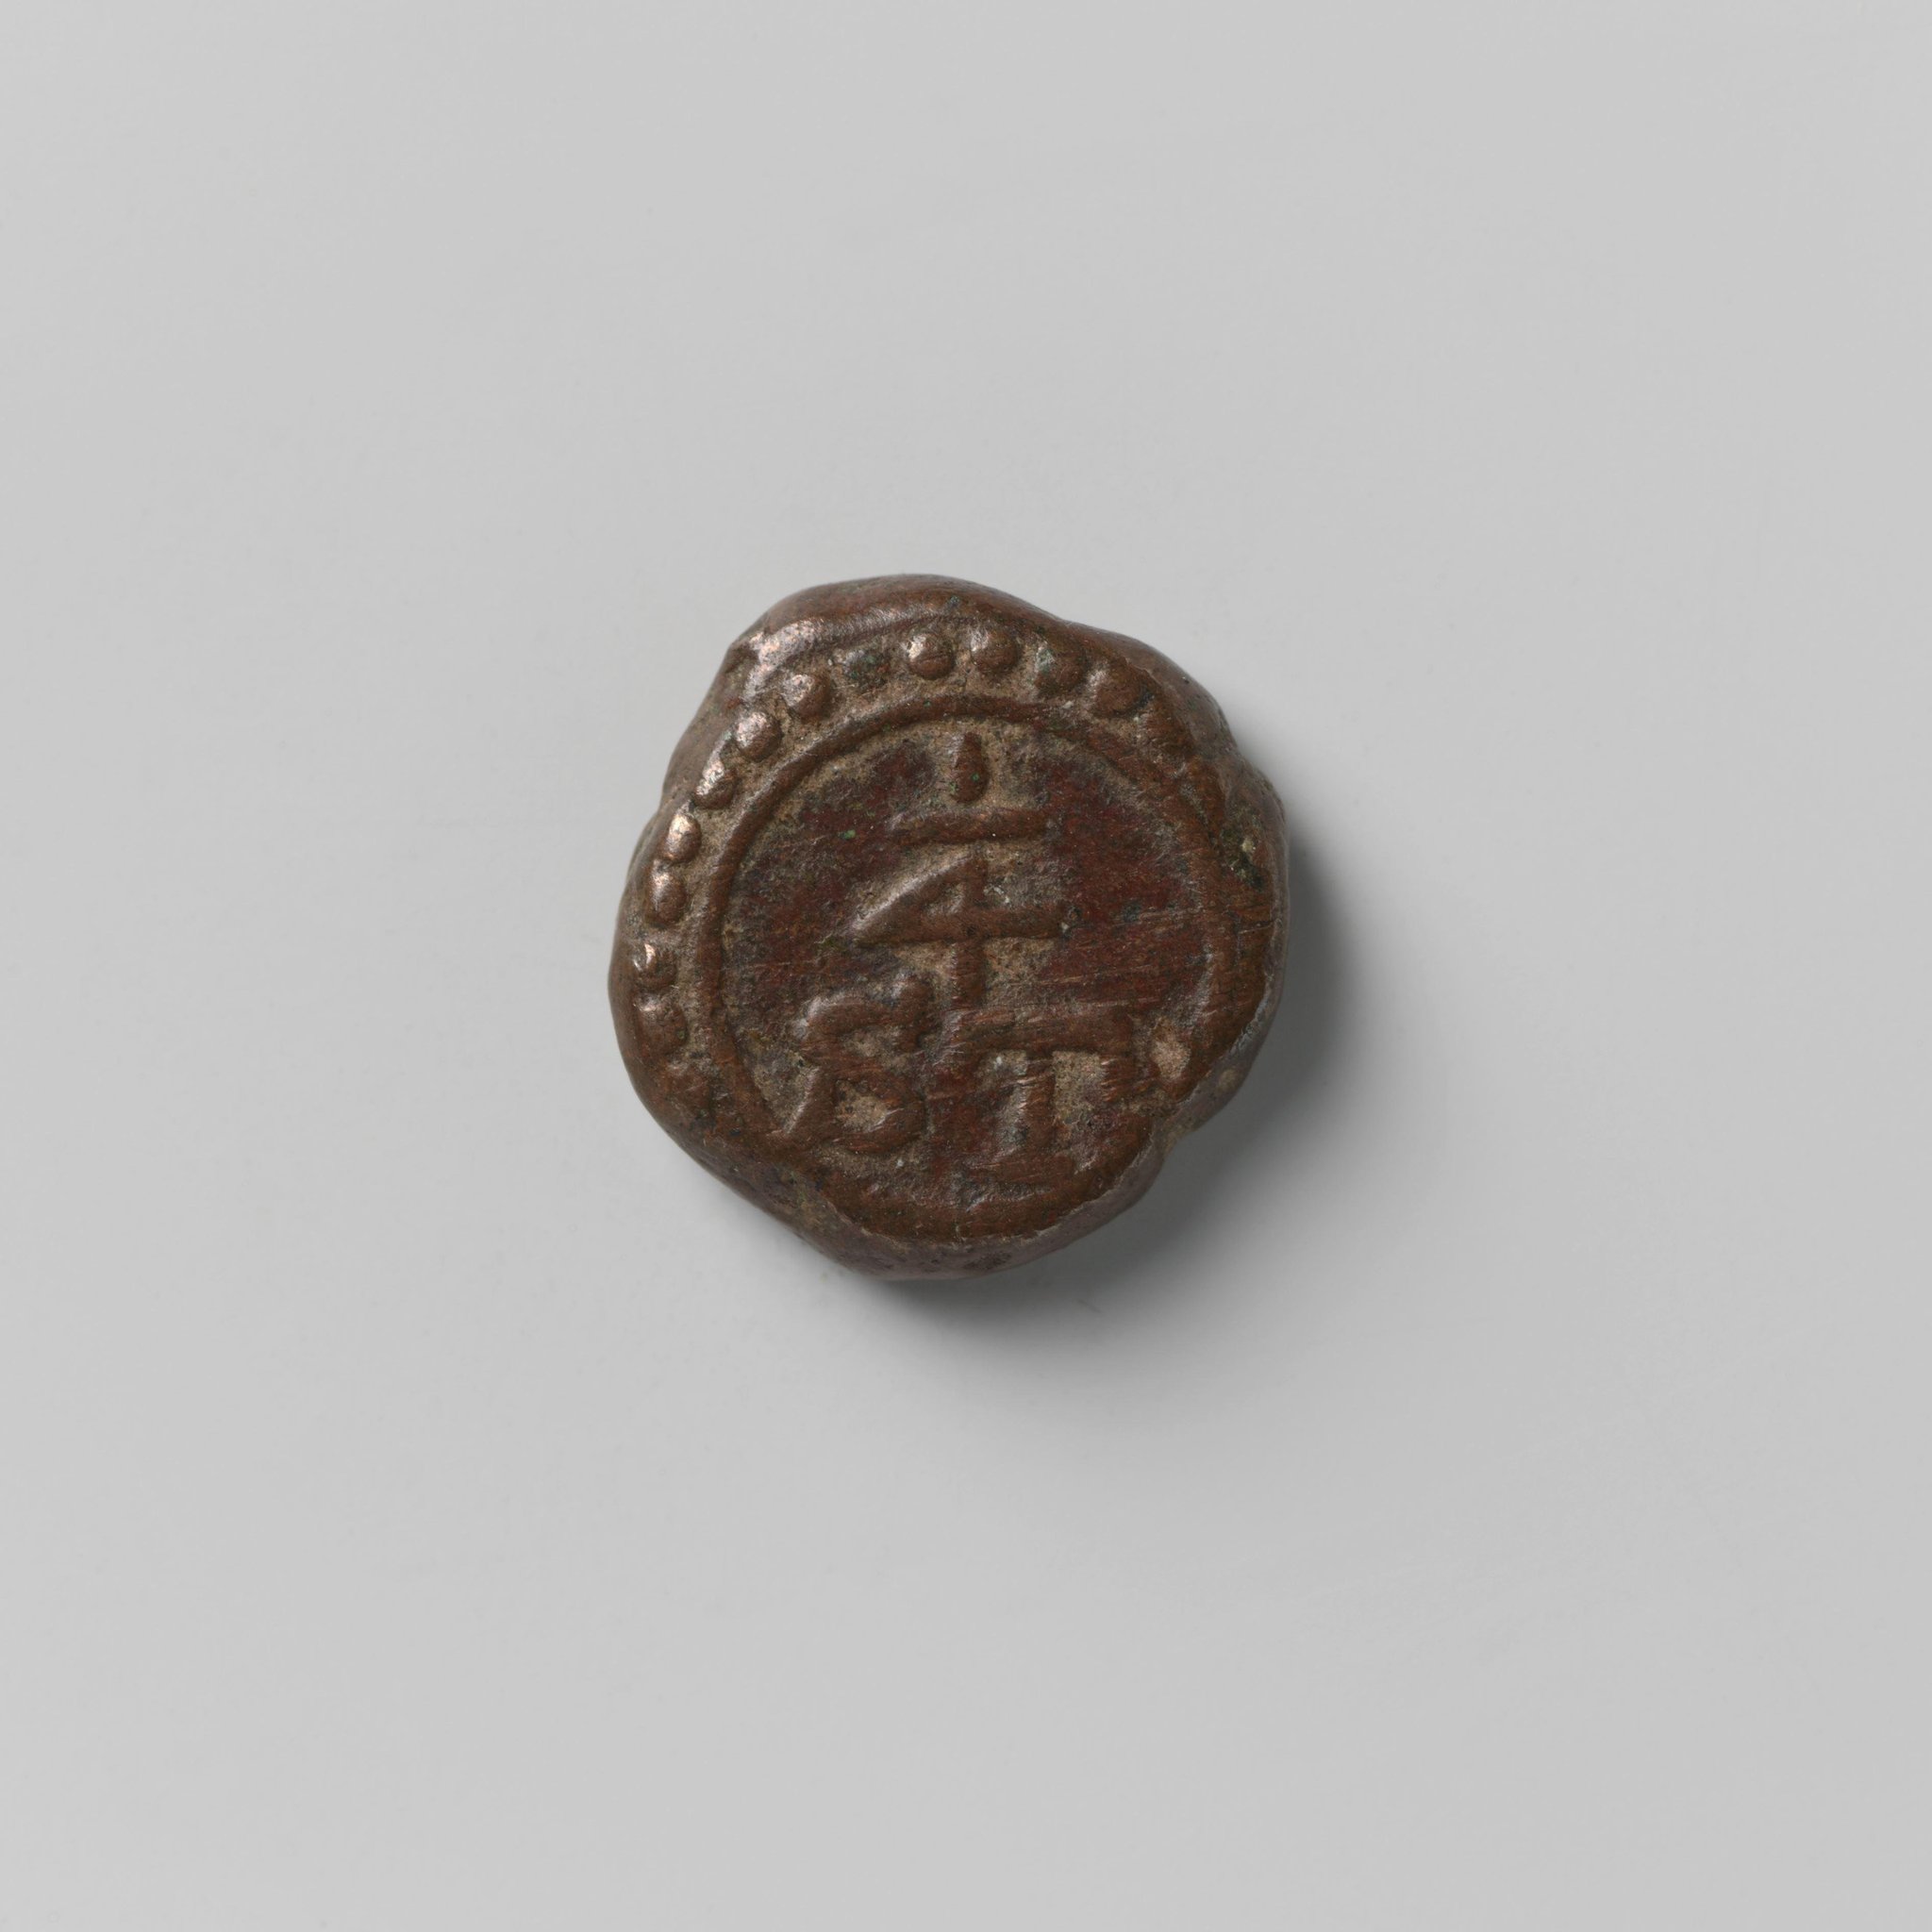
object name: coin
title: 1/4 stuiver van Ceylon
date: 1783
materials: copper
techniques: striking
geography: colombo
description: Koperen munt. Voorzijde: monogram van de VOC, waarboven letter C. Keerzijde: waarde-aanduiding ST, waarboven I/4 . Gladde rand.